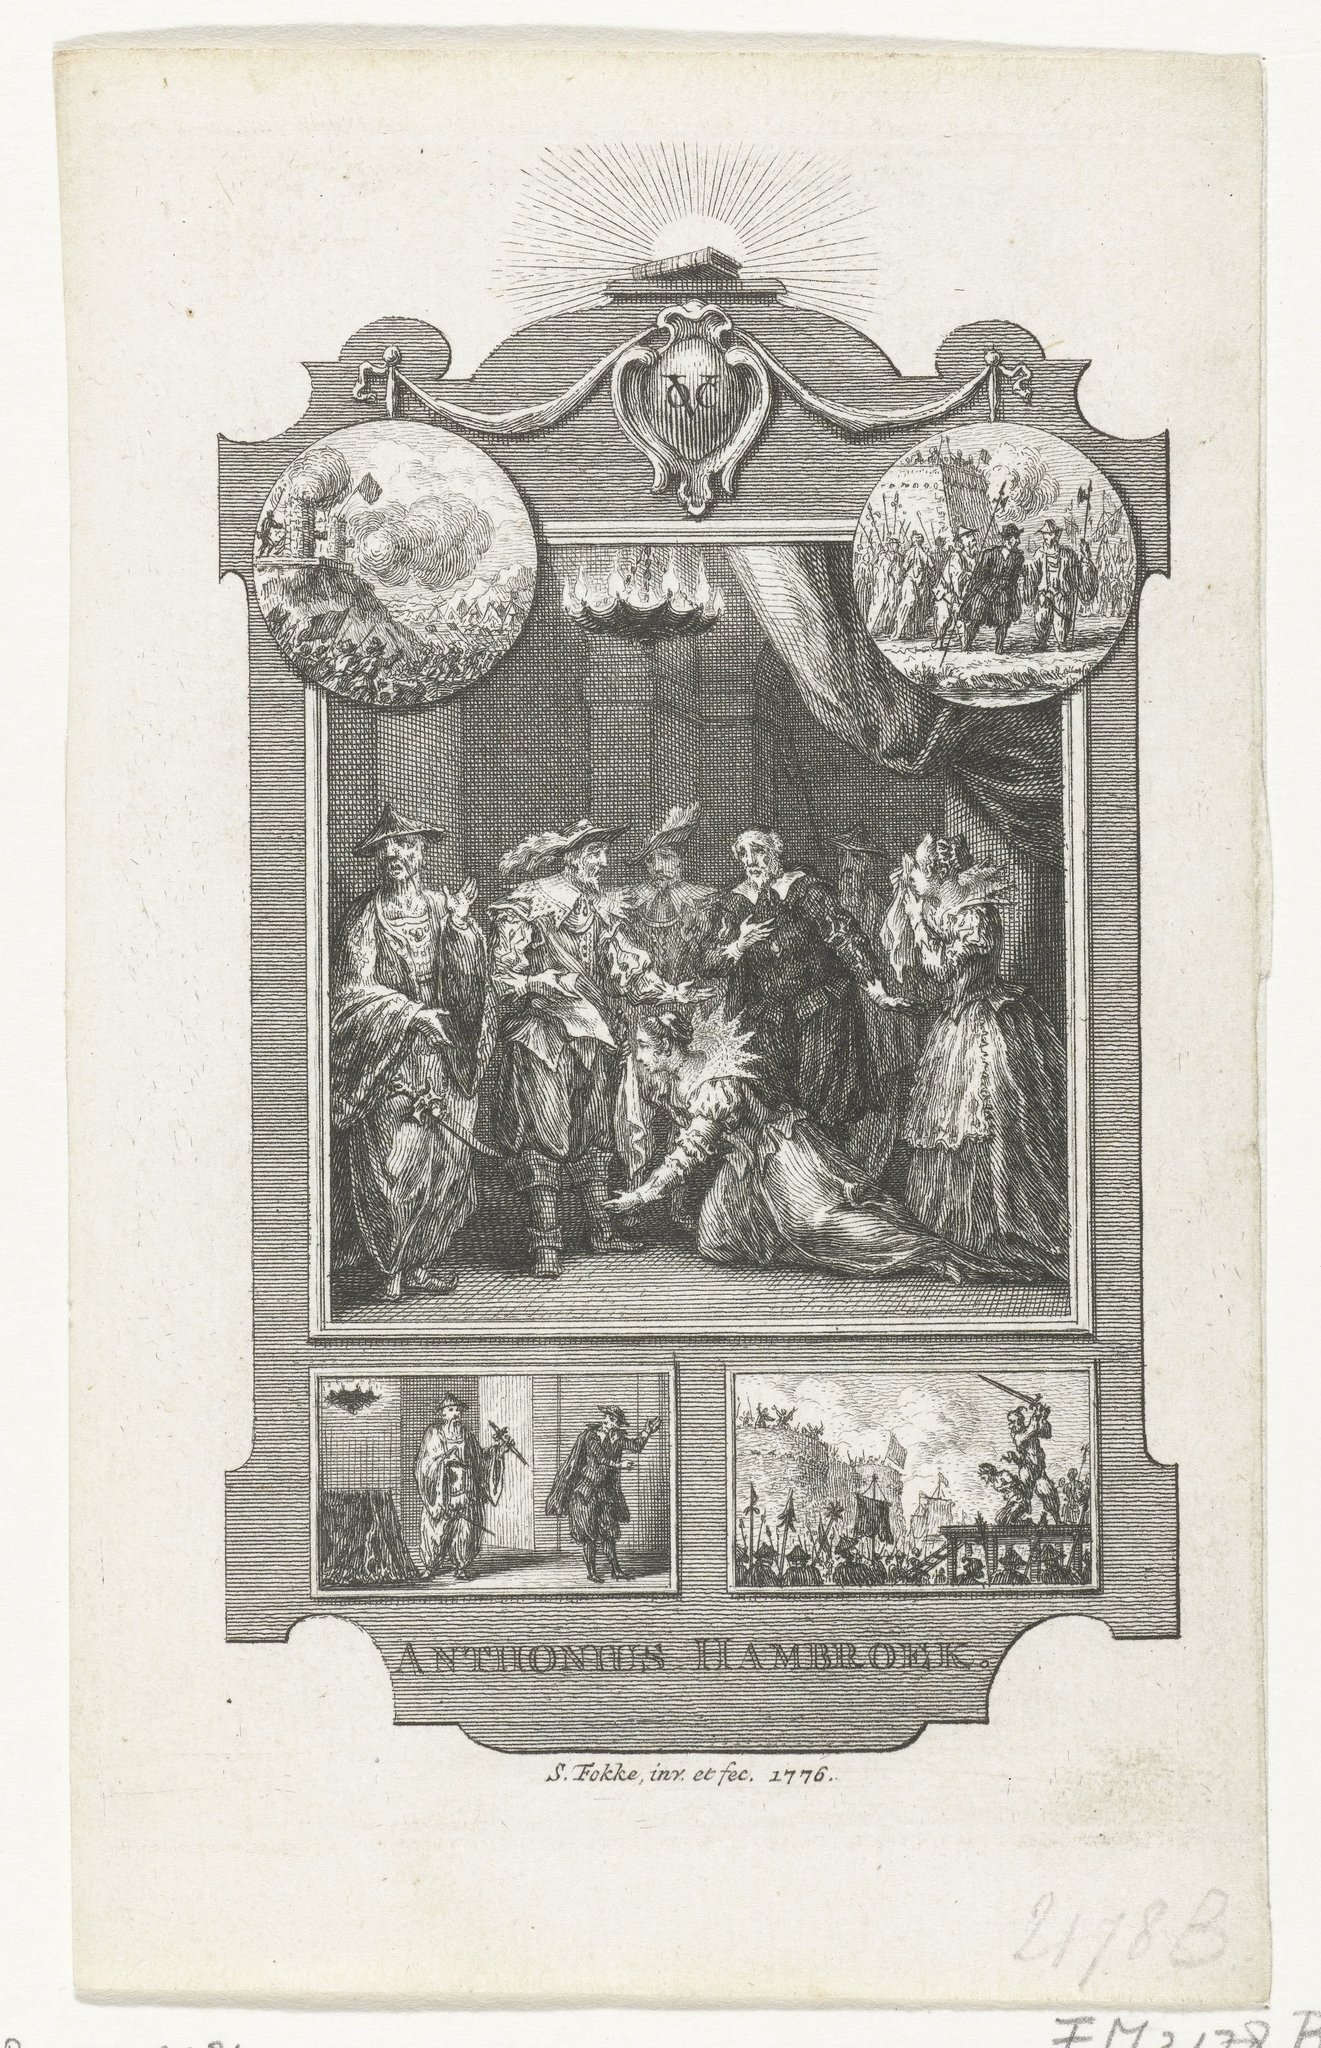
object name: history print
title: De zelfopoffering van predikant Hambroeck op Formosa, 1661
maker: simon fokke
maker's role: draughtsman, print maker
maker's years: 1712-1784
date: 1776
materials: paper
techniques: etching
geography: northern netherlands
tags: rotterdam, formosa, asking someone not to leave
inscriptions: date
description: De zelfopoffering van predikant Hambroeck op Formosa. Na het verzoek om overgave van de Chinezen persoonlijk te hebben overgebracht aan de Hollandse bevelhebbers van Fort Zeelandia op Formosa, neemt Hambroeck afscheid van zijn dochters en keert terug naar de Chinese zeerover Coxinga, 24 mei 1661. In oktober 1661 wordt hij door de Chinezen vermoord. Centrale voorstelling waarin zijn dochters hem smeken niet te vertrekken, omringd door vier kleinere scènes en het vignet van de VOC.